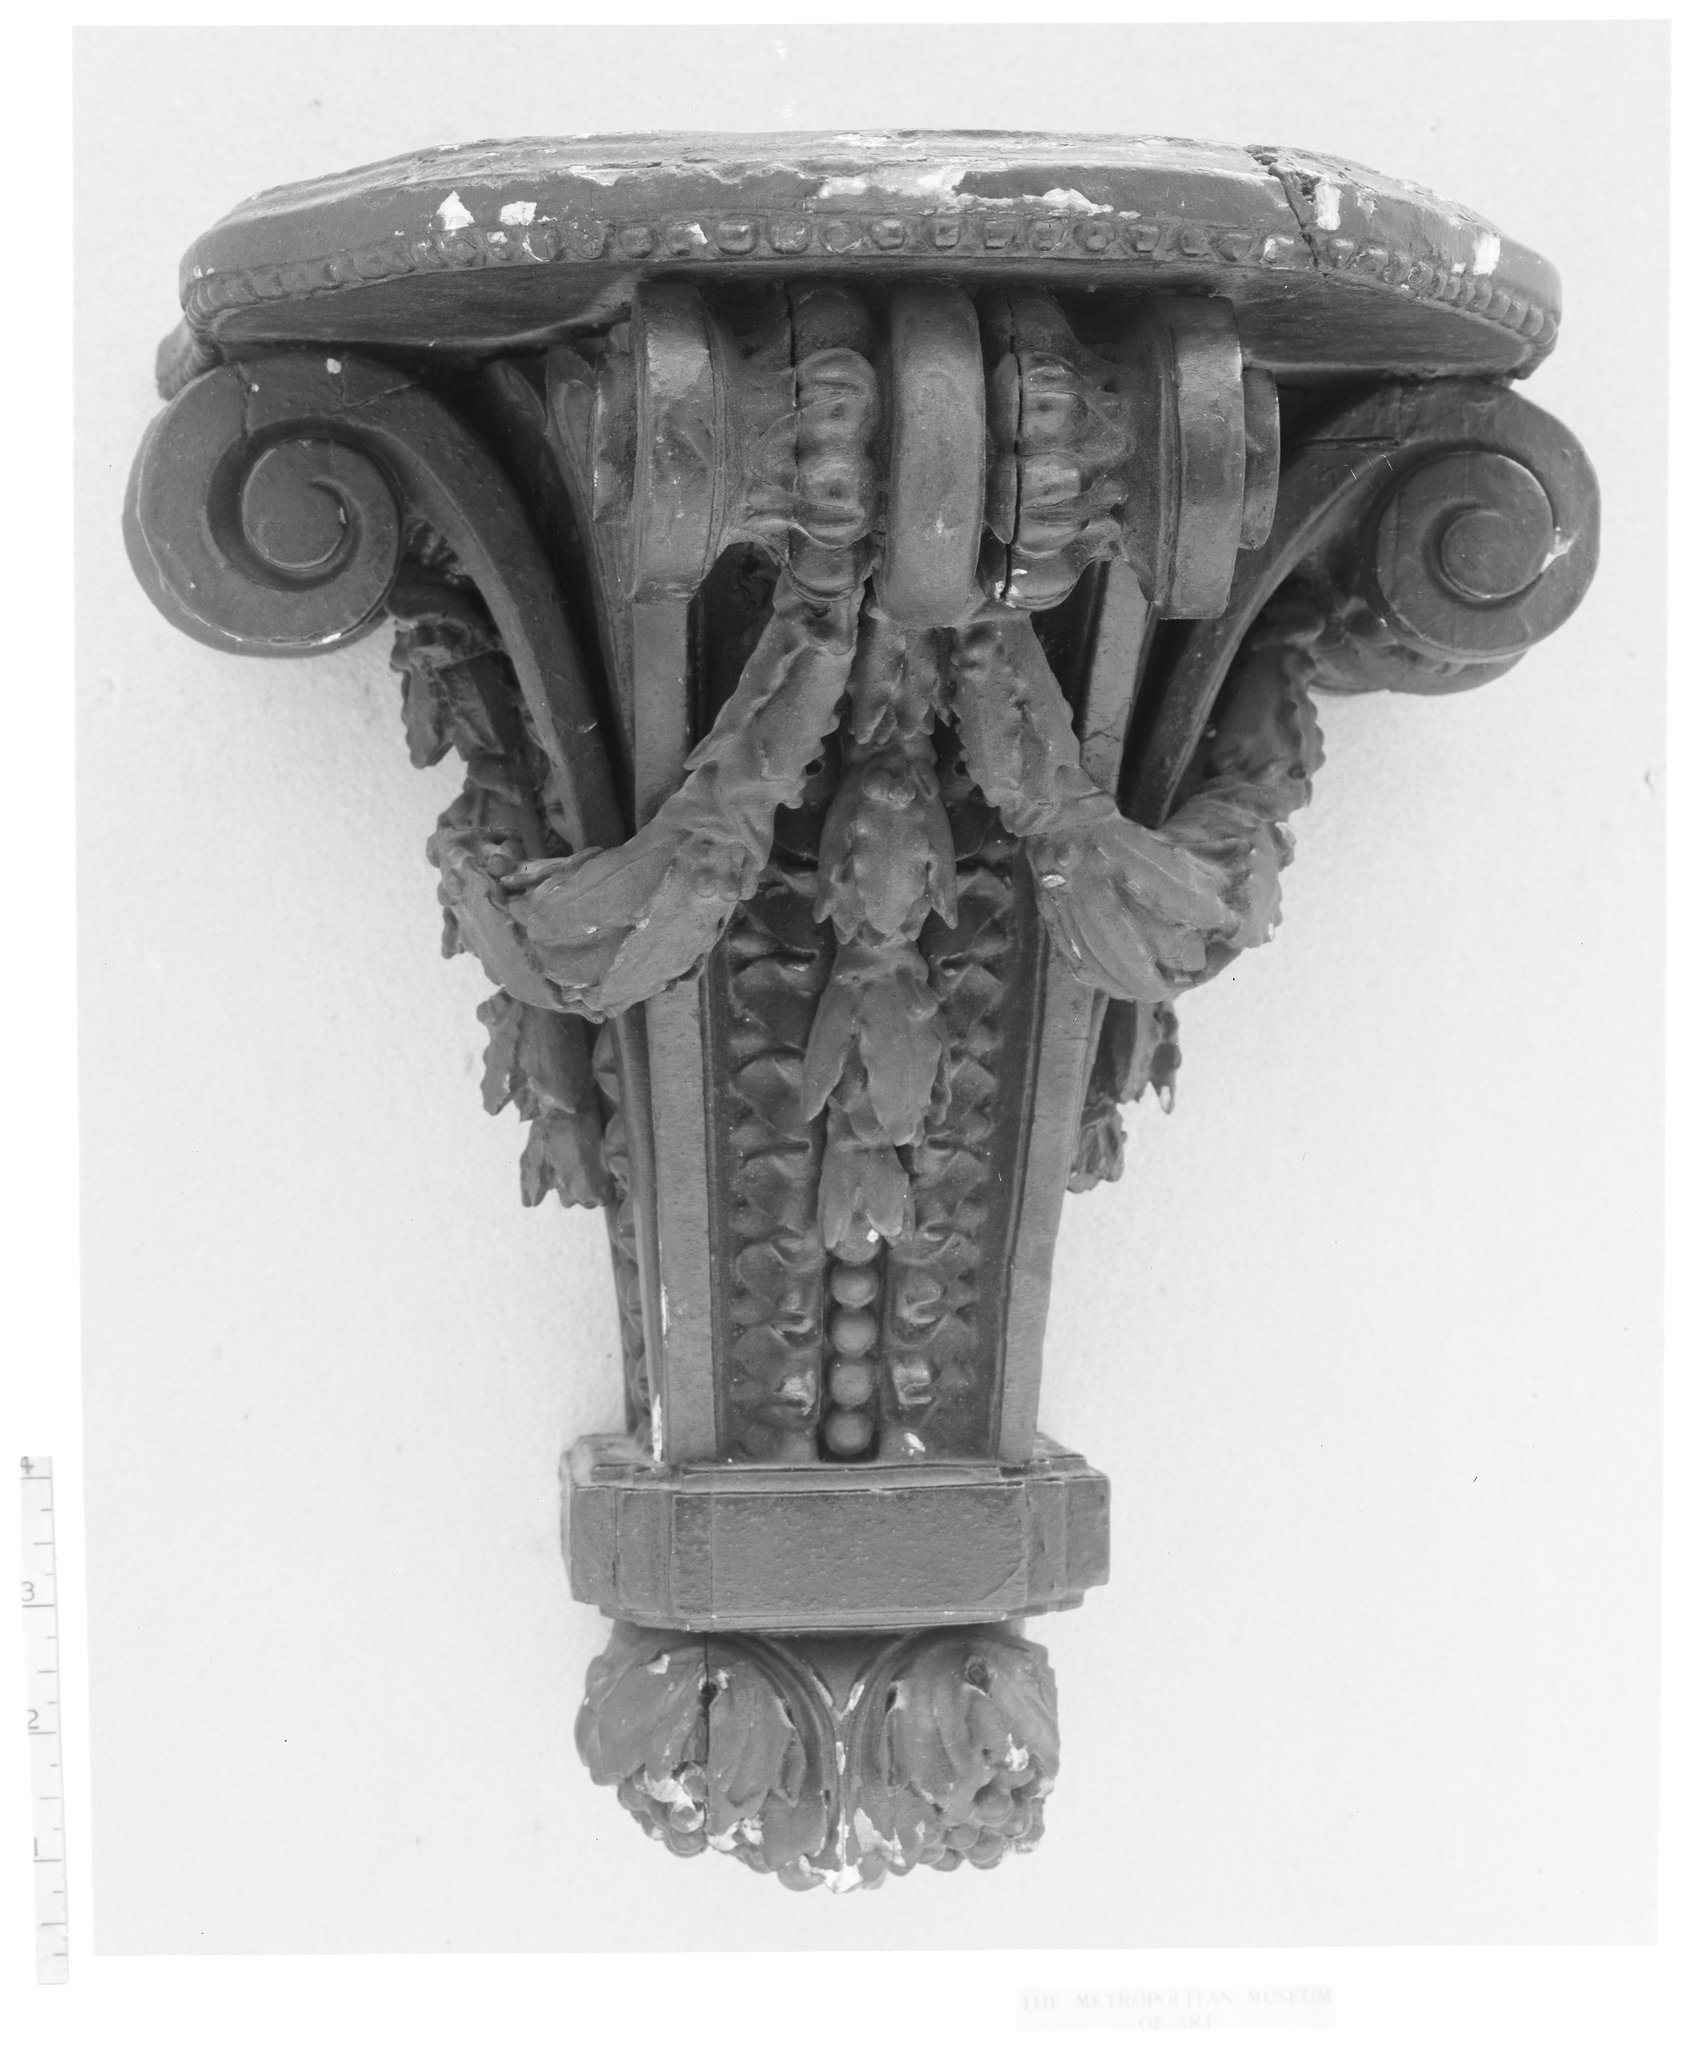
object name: console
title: Console d'applique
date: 1701-1800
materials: wood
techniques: carving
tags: leaves